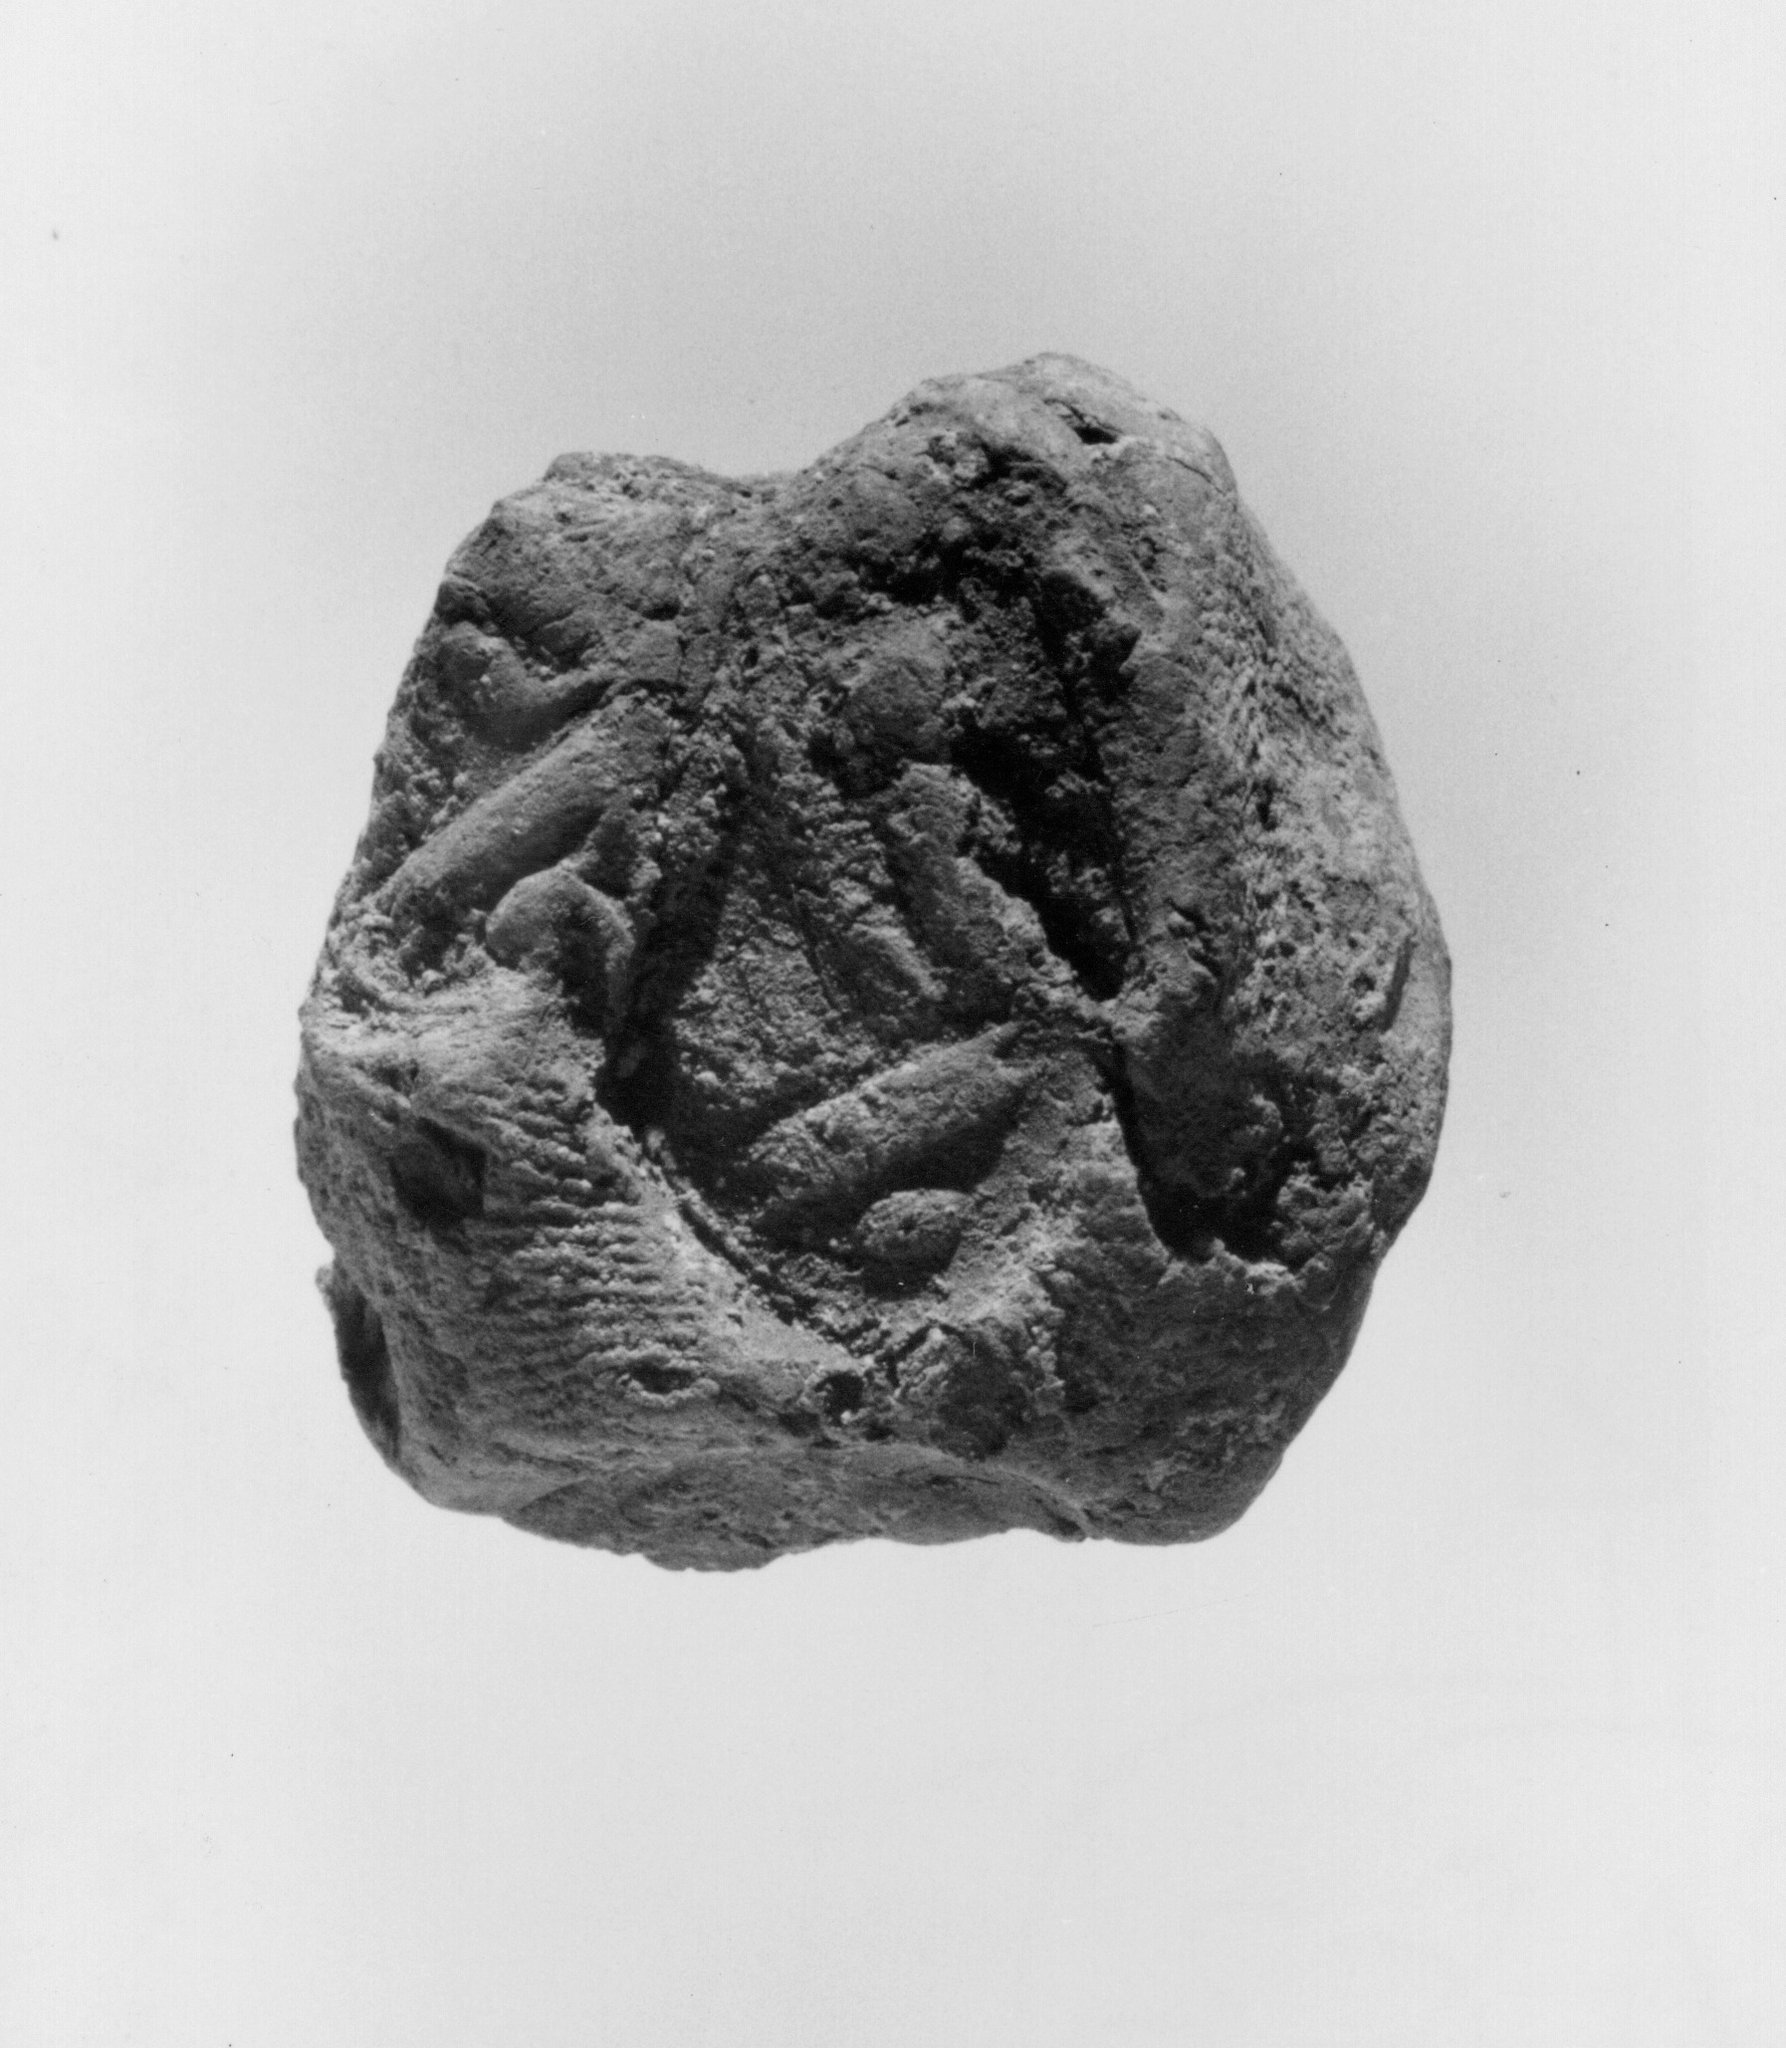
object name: sealing, nebmaatre, amenhotep iii, horus, re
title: Document Sealing With the Throne Name of Amenhotep III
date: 1390-1352 BCE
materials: mud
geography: egypt